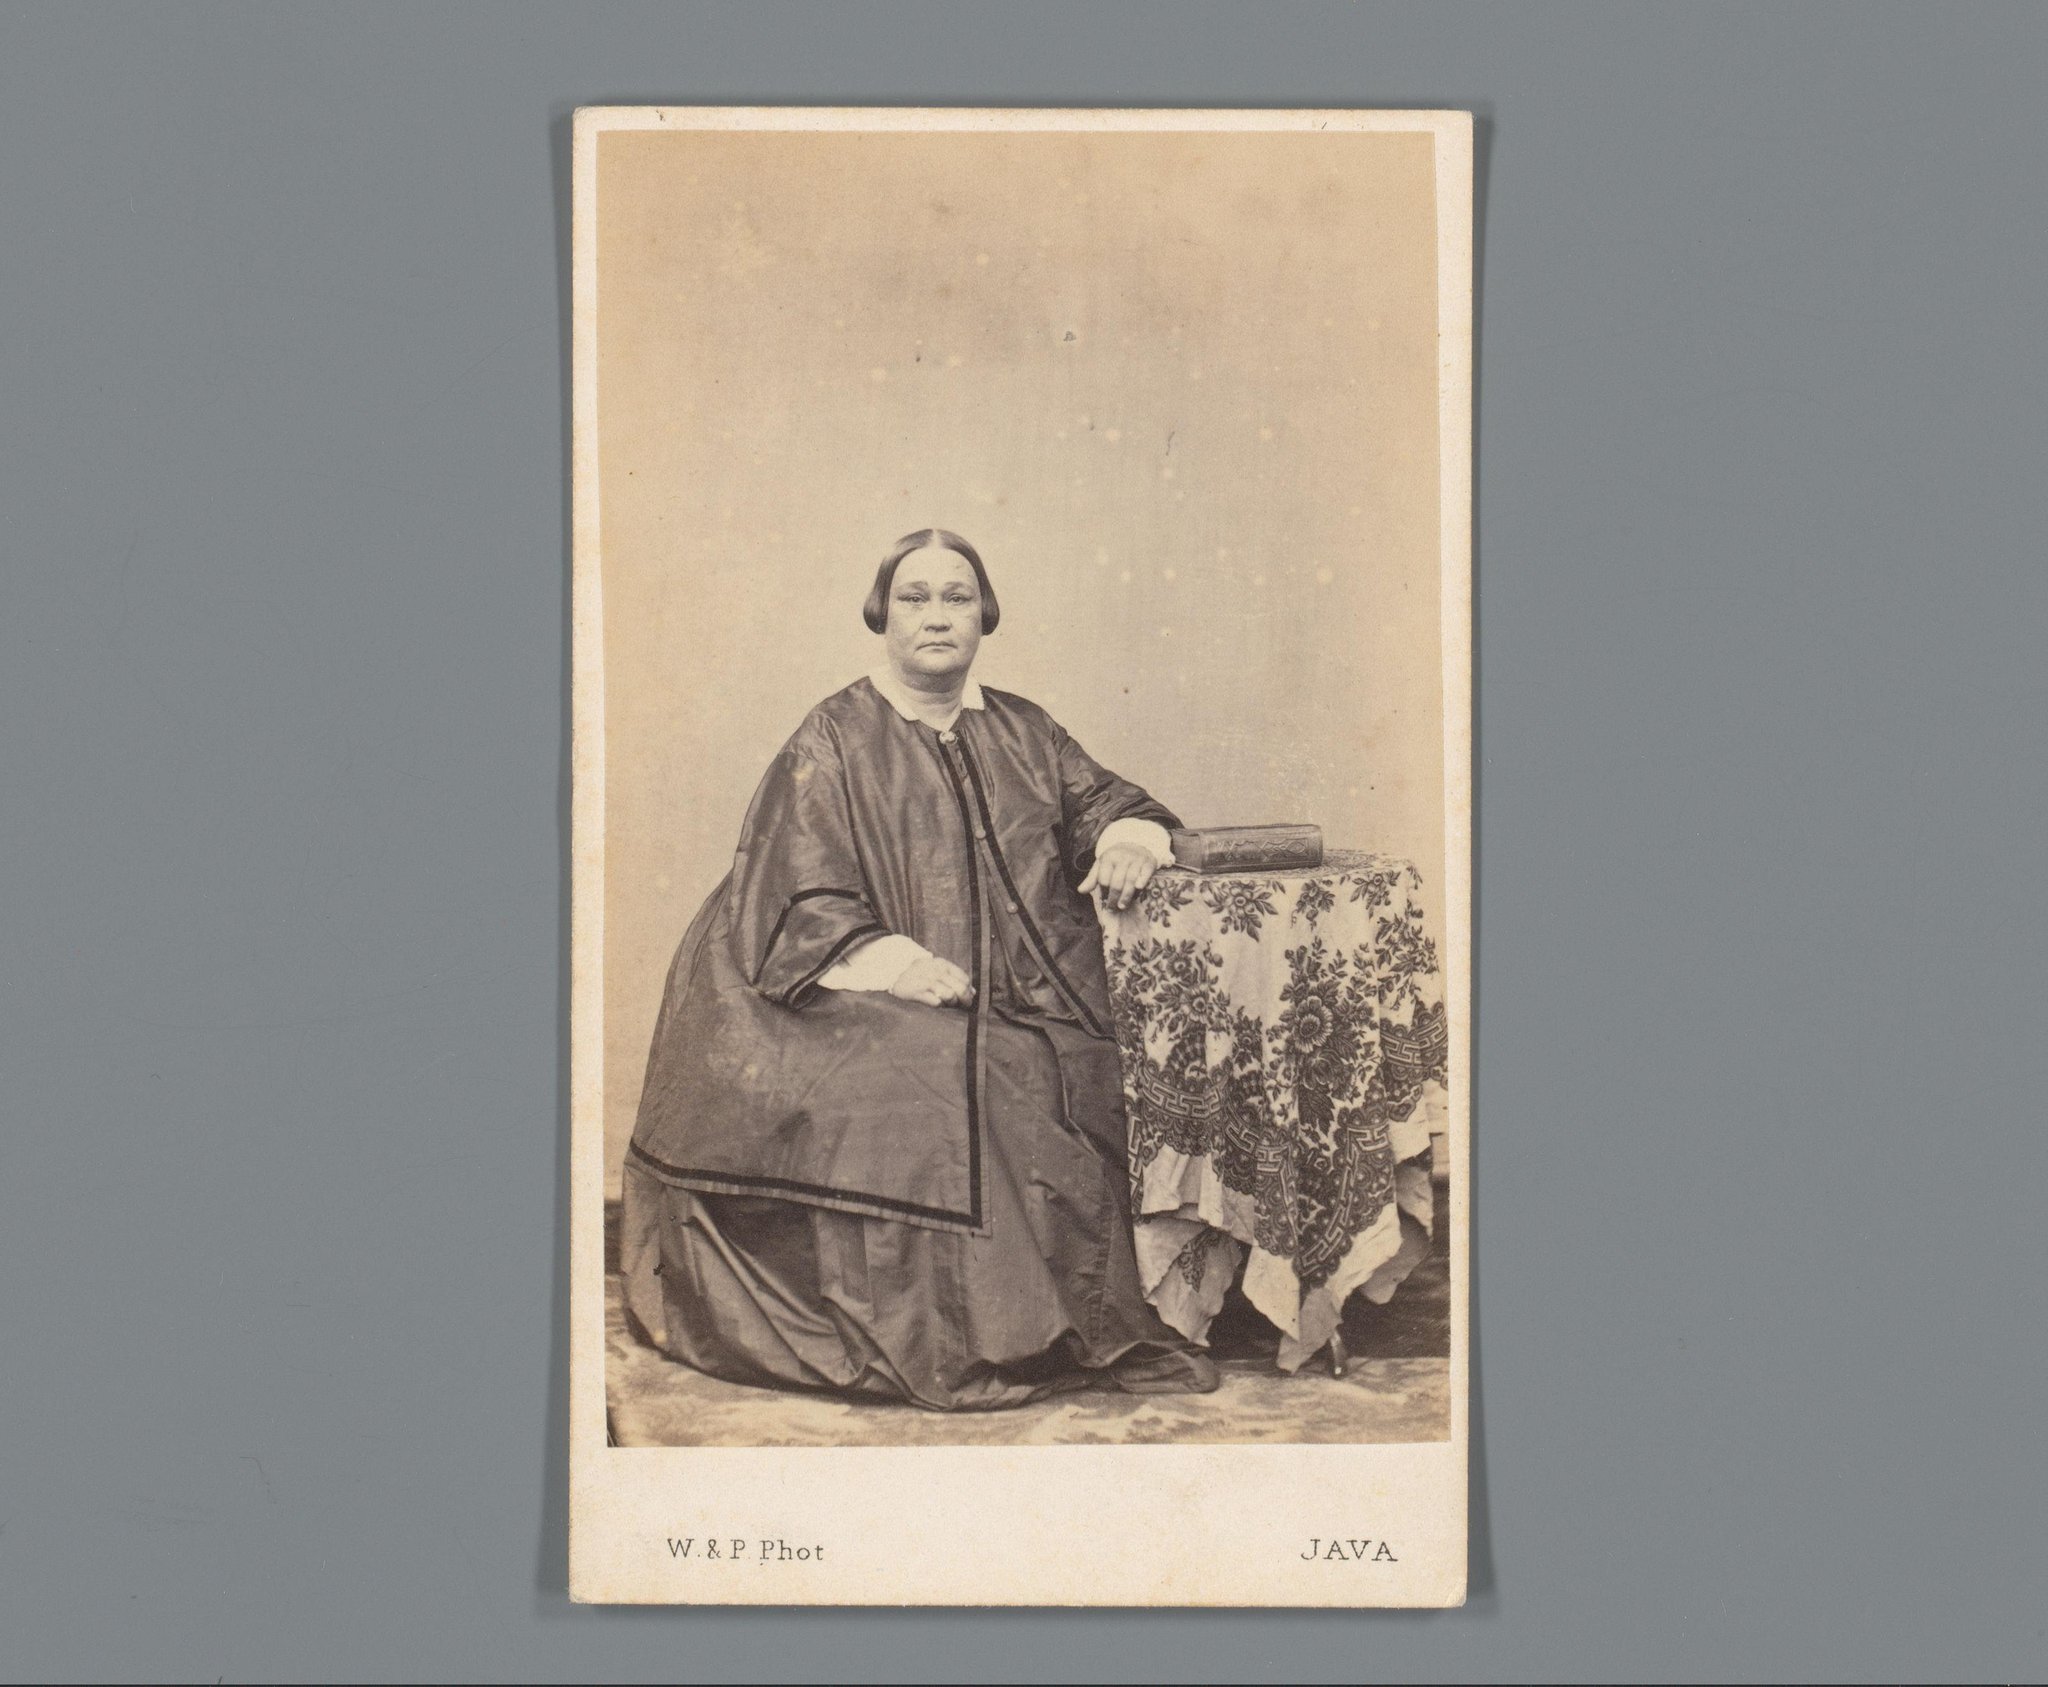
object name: carte de visite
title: Portret van een zittende vrouw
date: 1855-1899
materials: cardboard, photographic support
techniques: albumen print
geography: java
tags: anonymous historical person portrayed - bb - woman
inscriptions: inscription: ‘No. 1 7470 12 copies’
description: Portret van een zittende vrouw. Mogelijk een lid van de familie Swellengrebel.